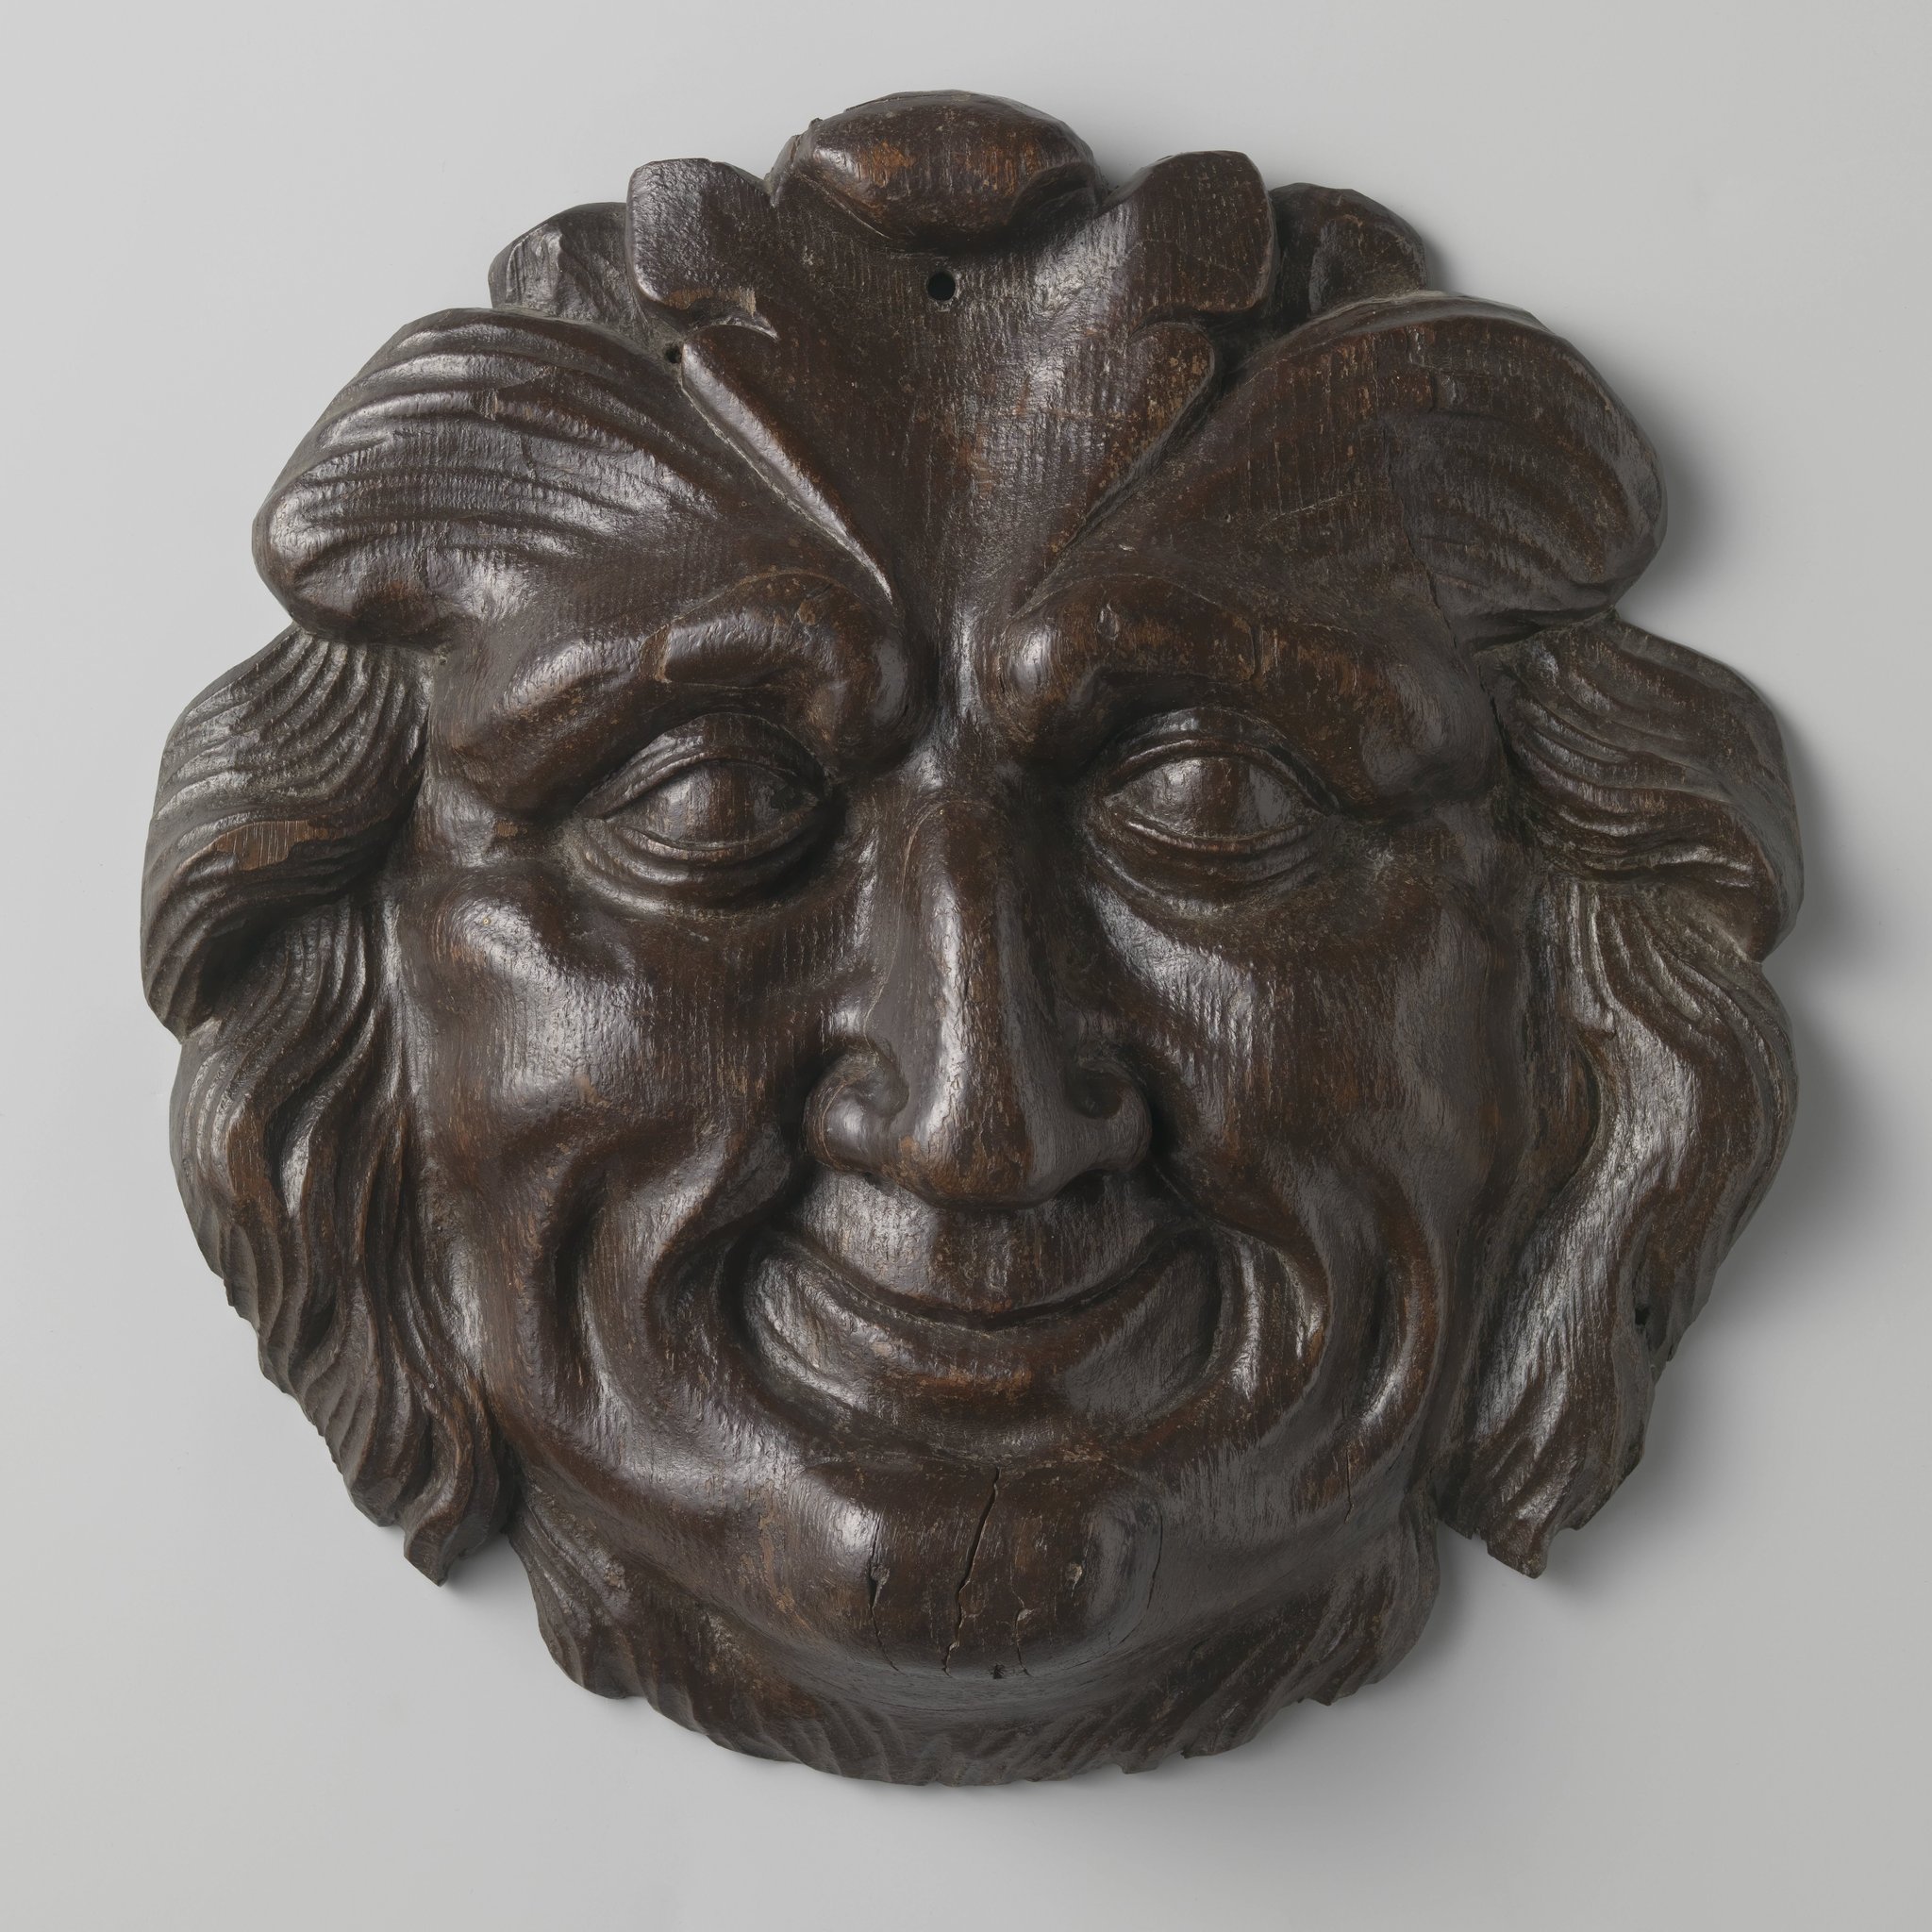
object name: sculpture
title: Mannenkop van hout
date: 1600-1699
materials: wood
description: Mannenkop van hout, gebeeldhouwd met lachende gezichtsuitdrukking.